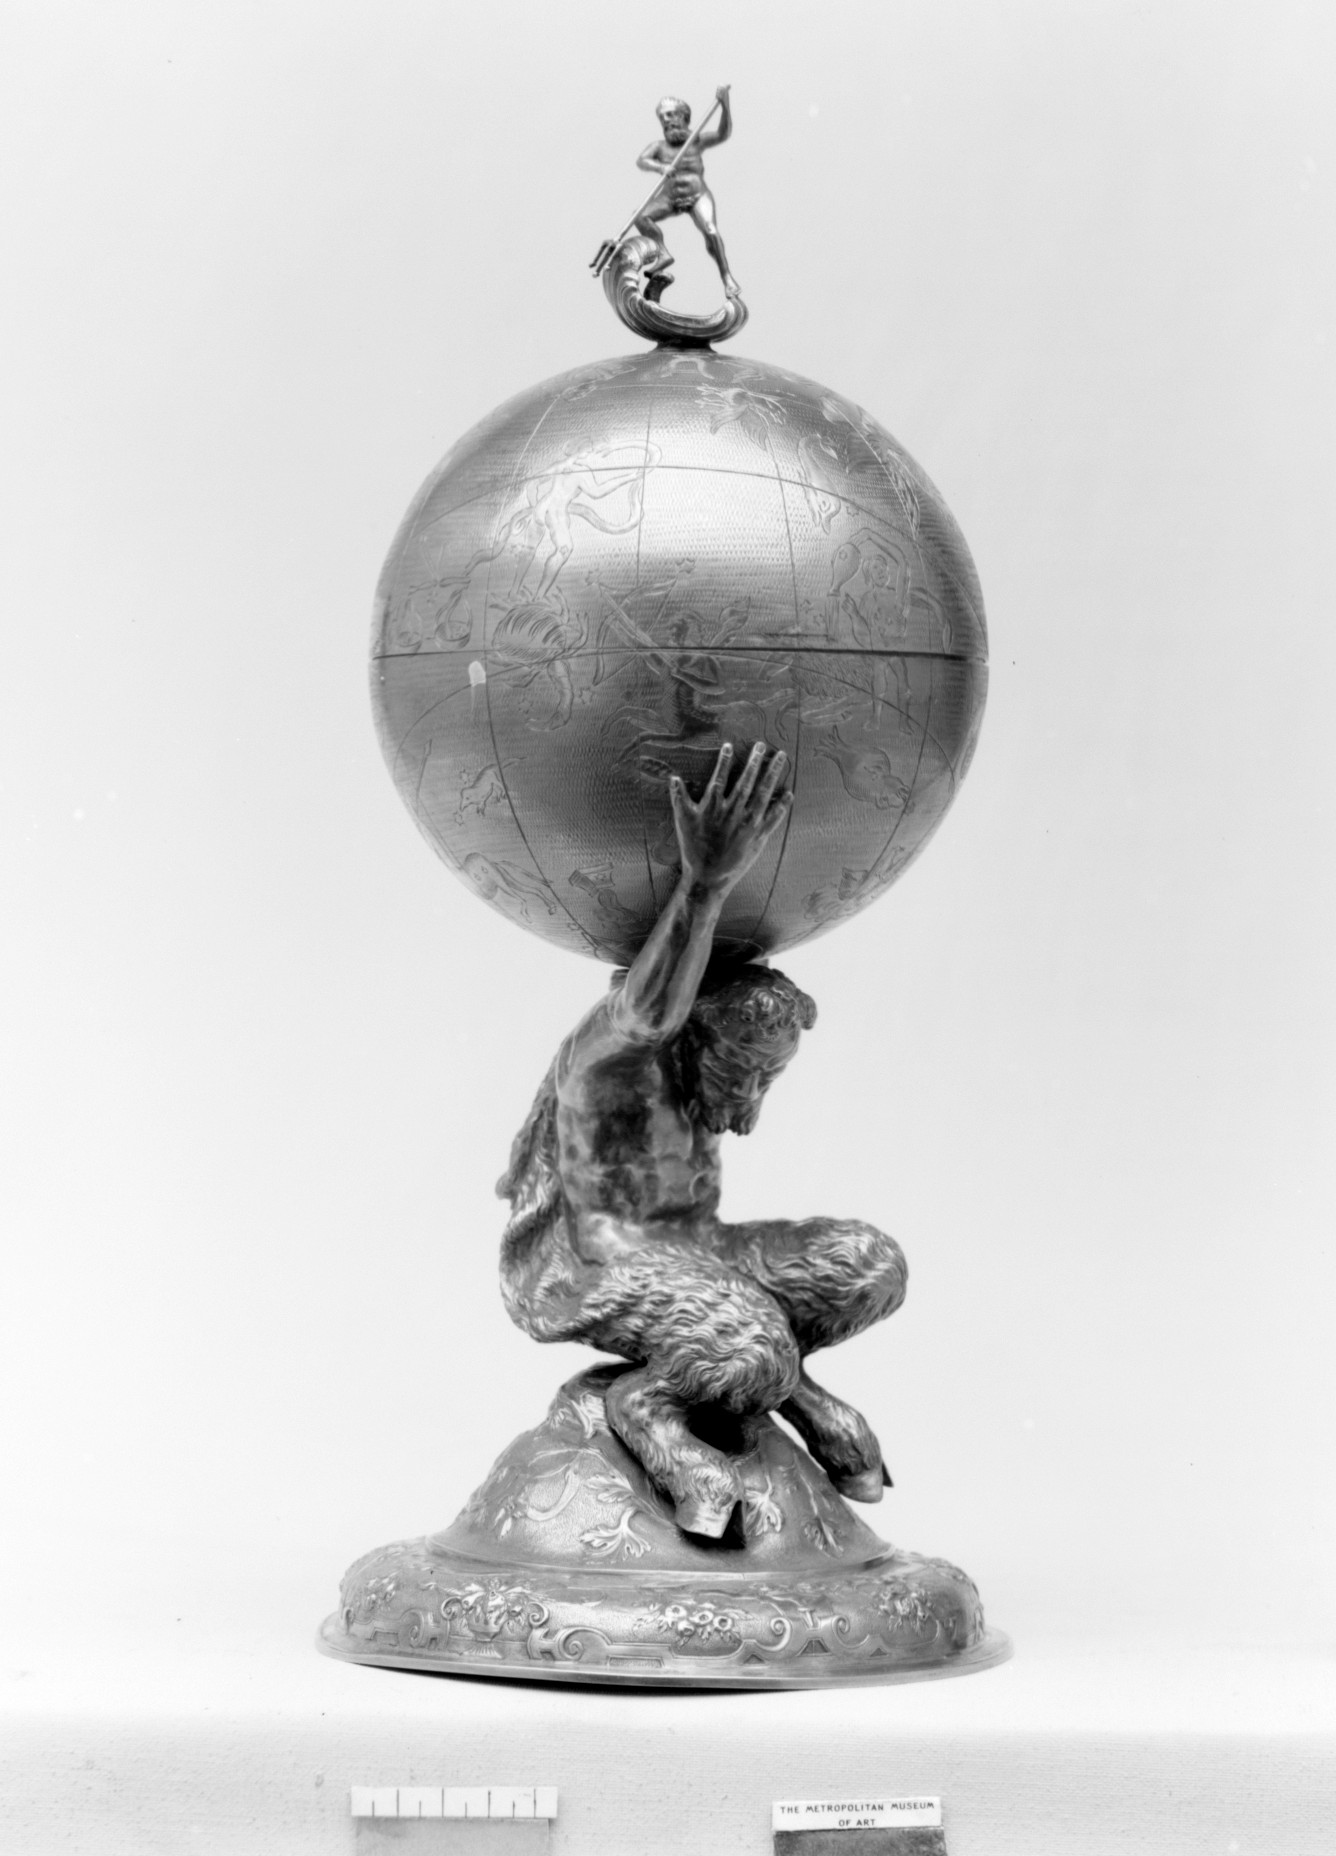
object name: cup with cover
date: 1801-1900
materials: gold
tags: satyrs,globes